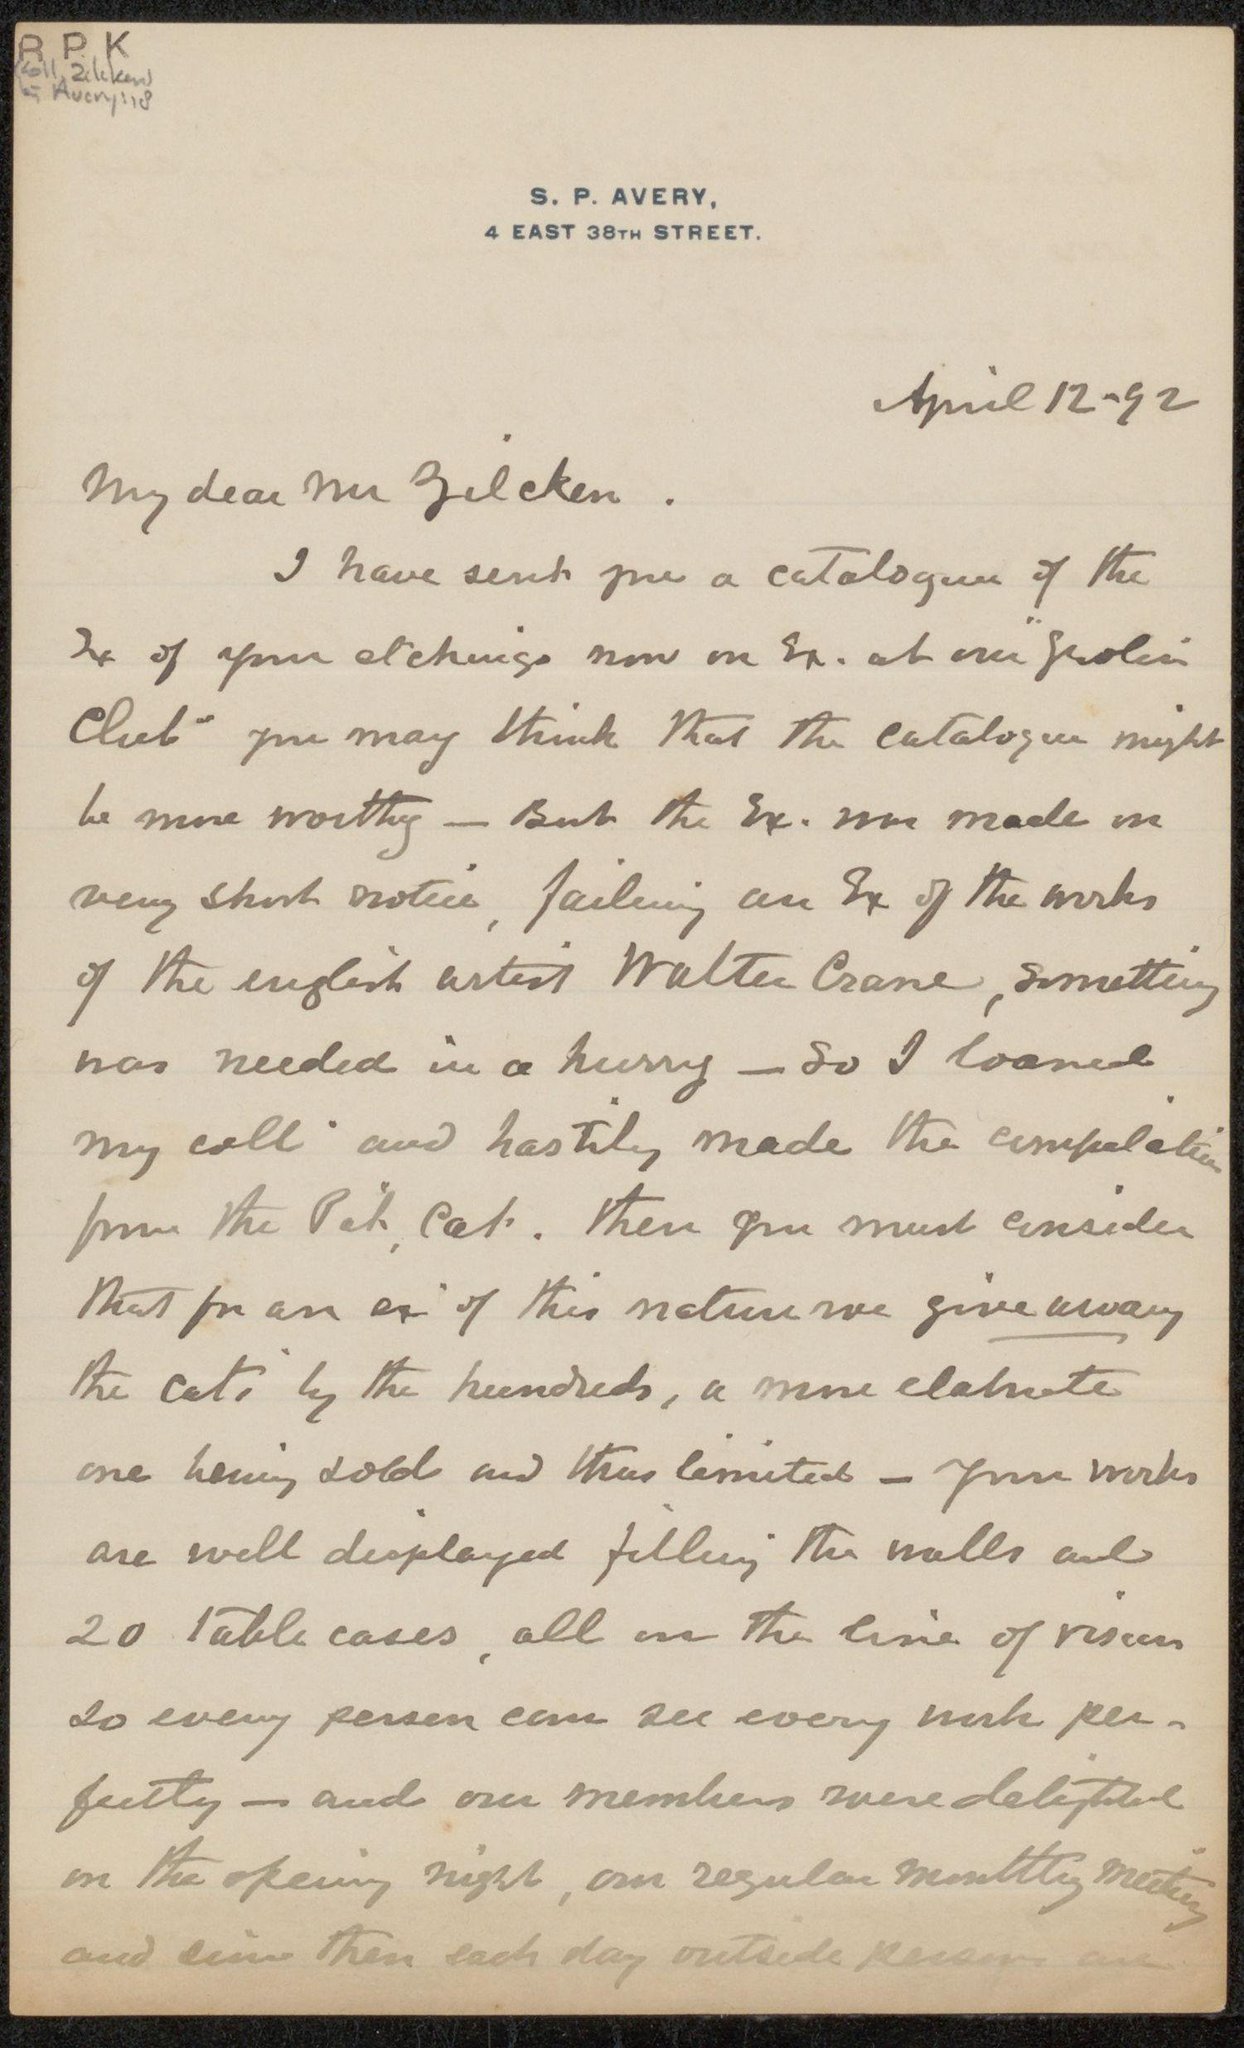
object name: letter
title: Brief aan Philip Zilcken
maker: samuel putnam avery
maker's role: verzamelaar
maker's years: 1822-1904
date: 1892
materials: ink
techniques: pen, printing, writing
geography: new york city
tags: the hague, draughtsman, philip zilcken, the graphic arts, temporary exhibition, 'salon'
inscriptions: collector's mark: ‘RPK’